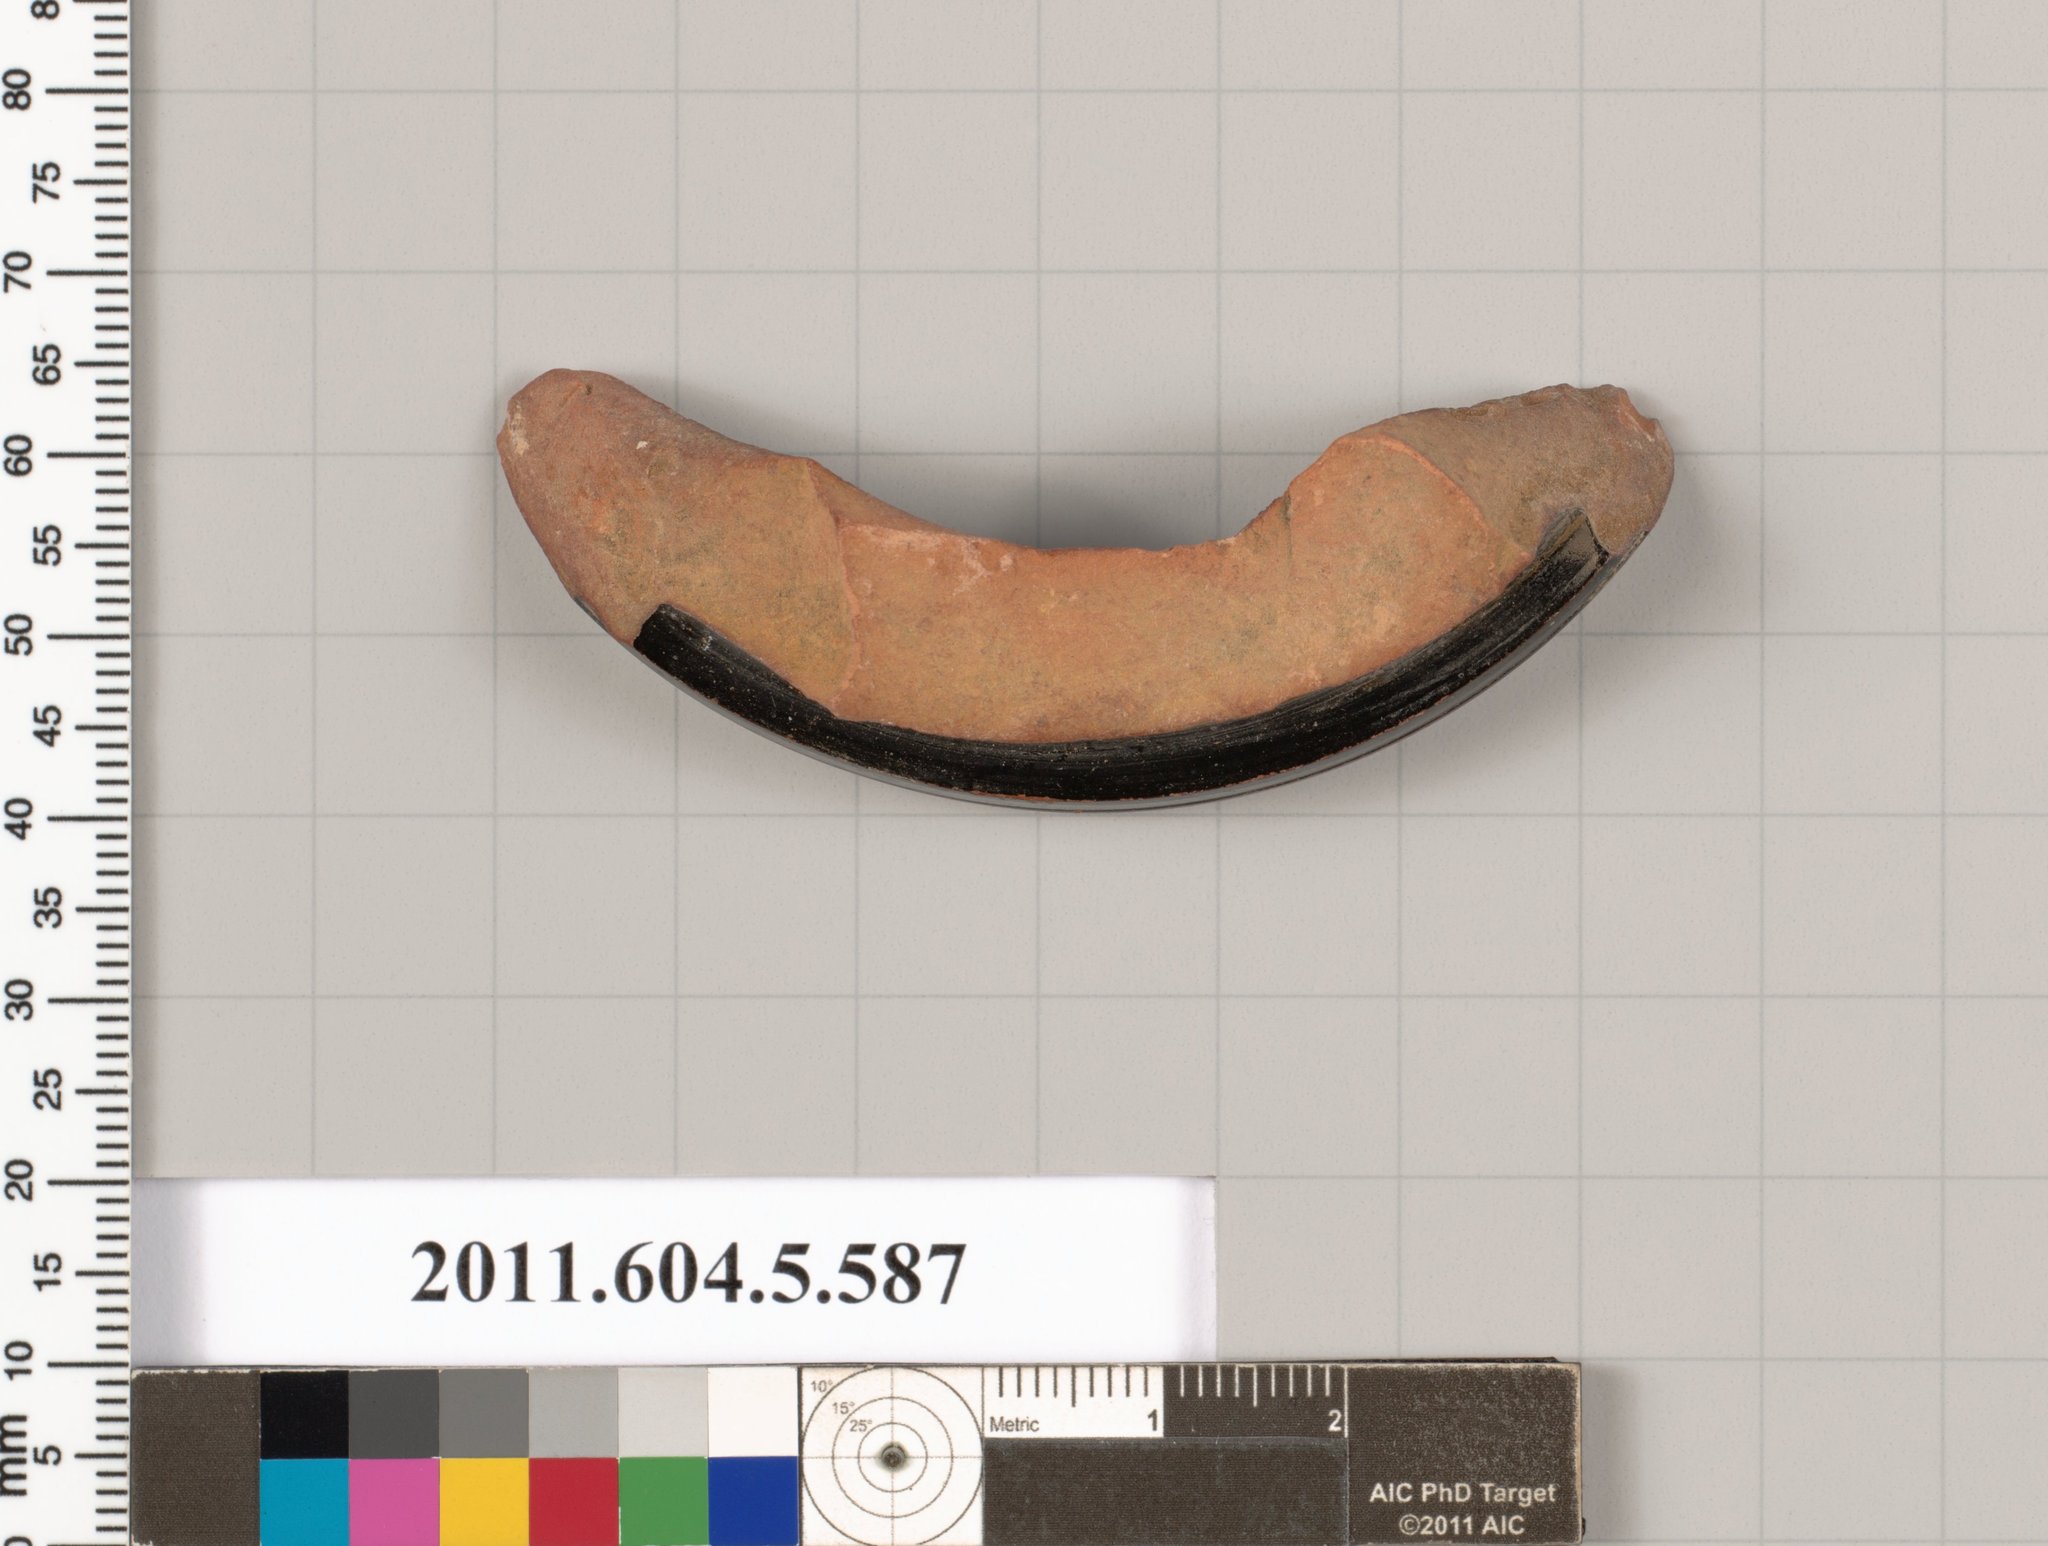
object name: stemless kylix fragment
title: Terracotta fragment of a stemless kylix (drinking cup)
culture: greek, attic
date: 600-401 BCE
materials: terracotta